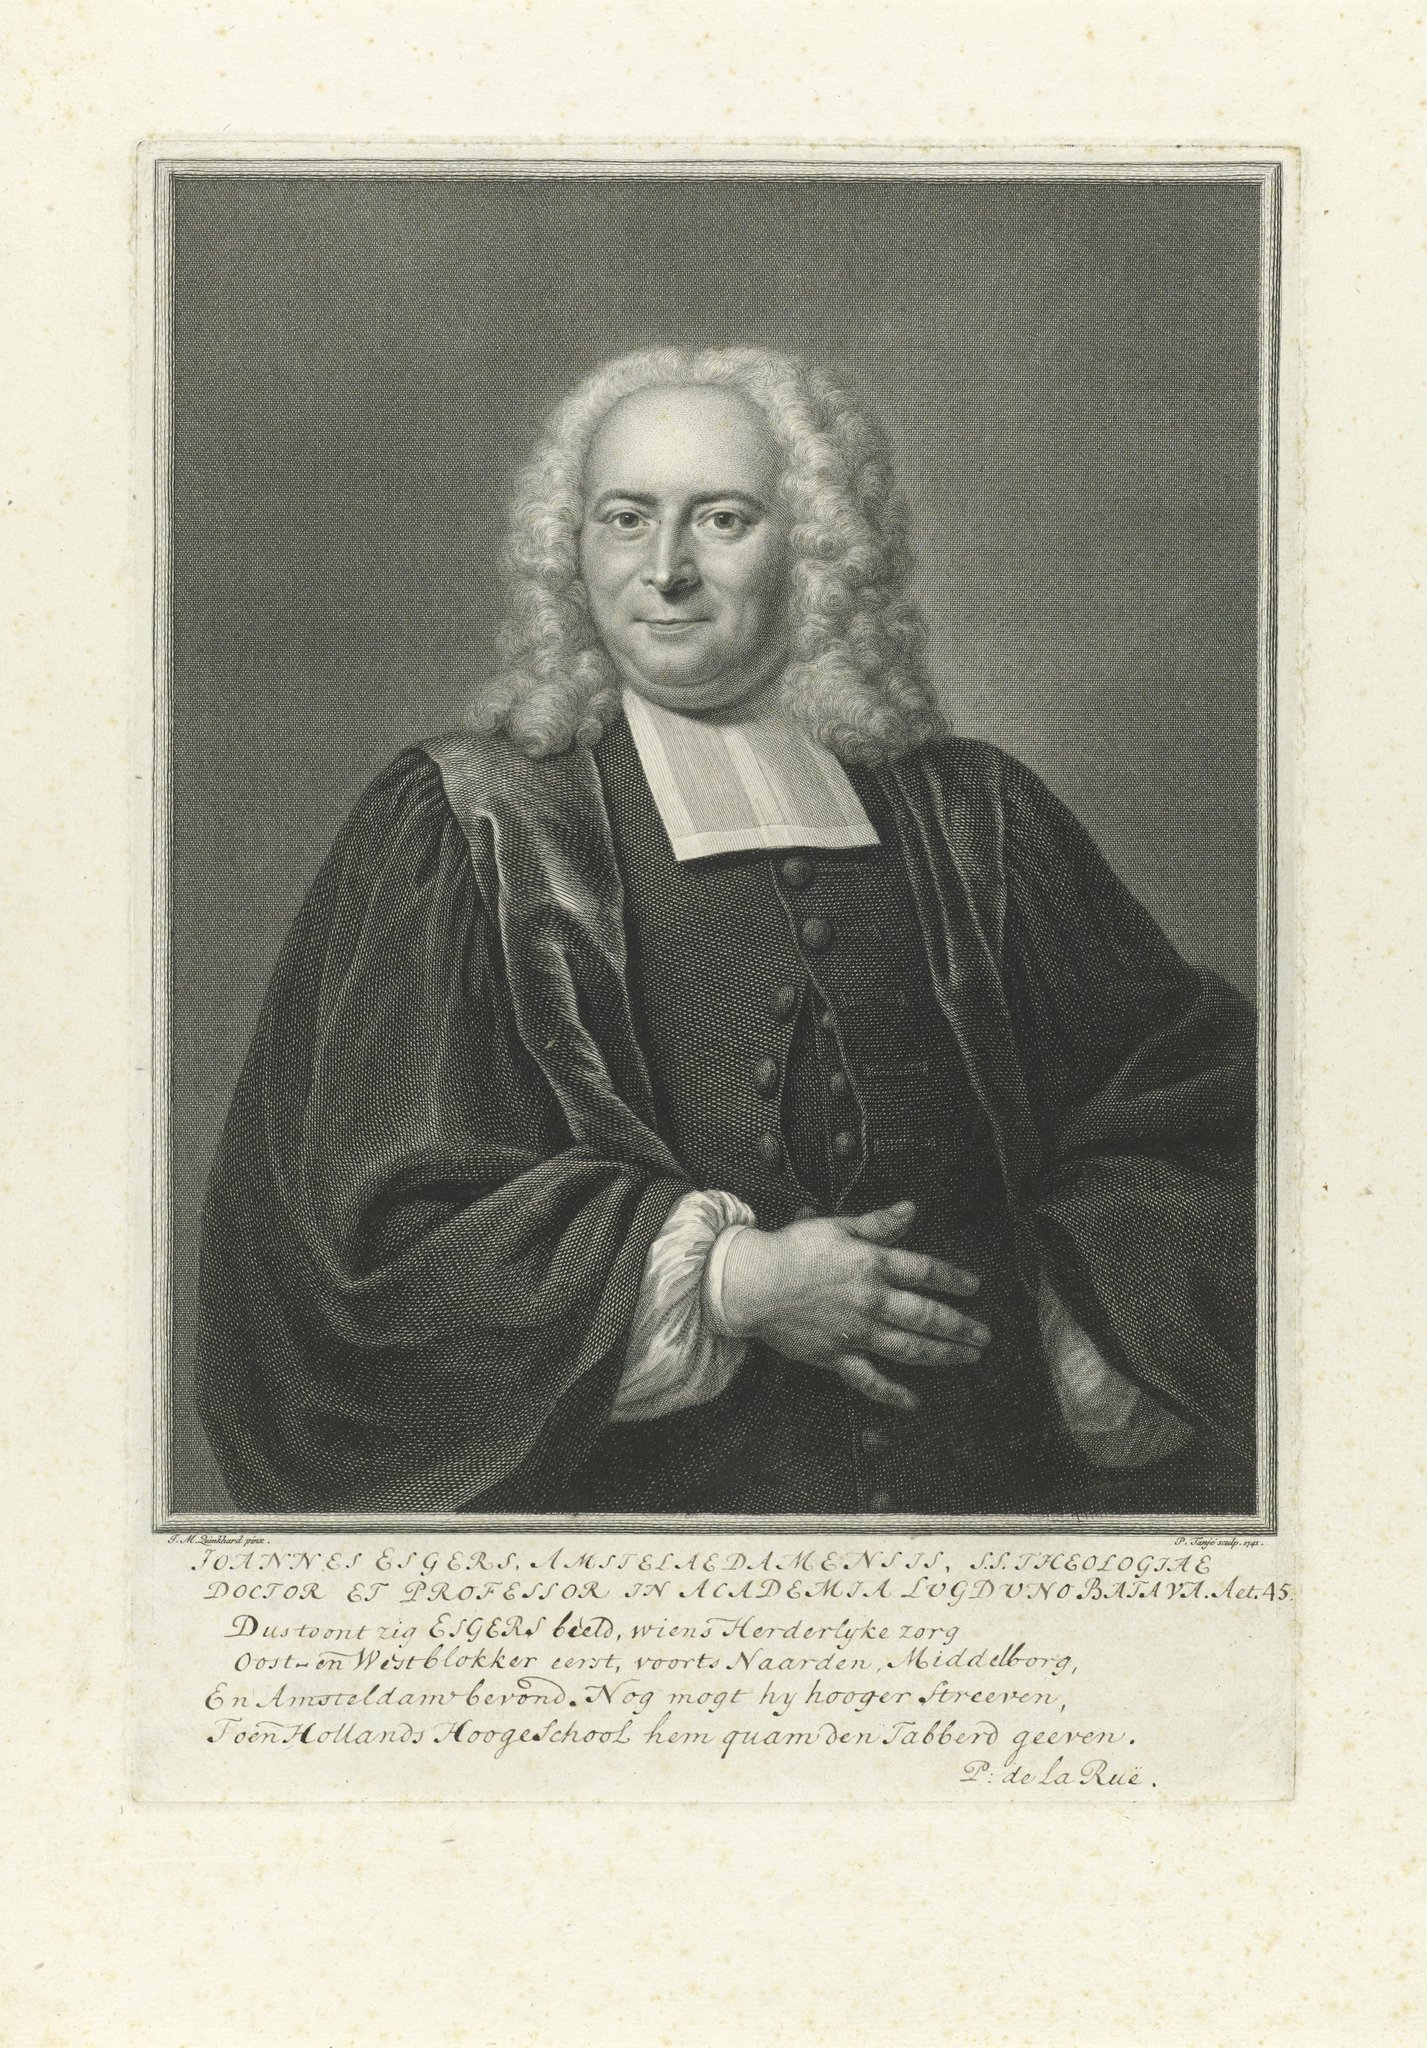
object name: print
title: Portret van Johannes Esgers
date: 1741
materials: paper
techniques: engraving, etching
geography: amsterdam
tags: predikant, hoogleraar, johannes esgers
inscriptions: collector's mark: Lugt 2228, inscription: ‘Joannes Esgers, Amstelaedamensis ... hem quam den Tabberd geeven. P: de la Ruë.’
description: Portret van Johannes Esgers. Hij was achtereenvolgens predikant te Ooster- en Westerblokker, Naarden, Middelburg en Amsterdam en tot slot hoogleraar te Leiden.